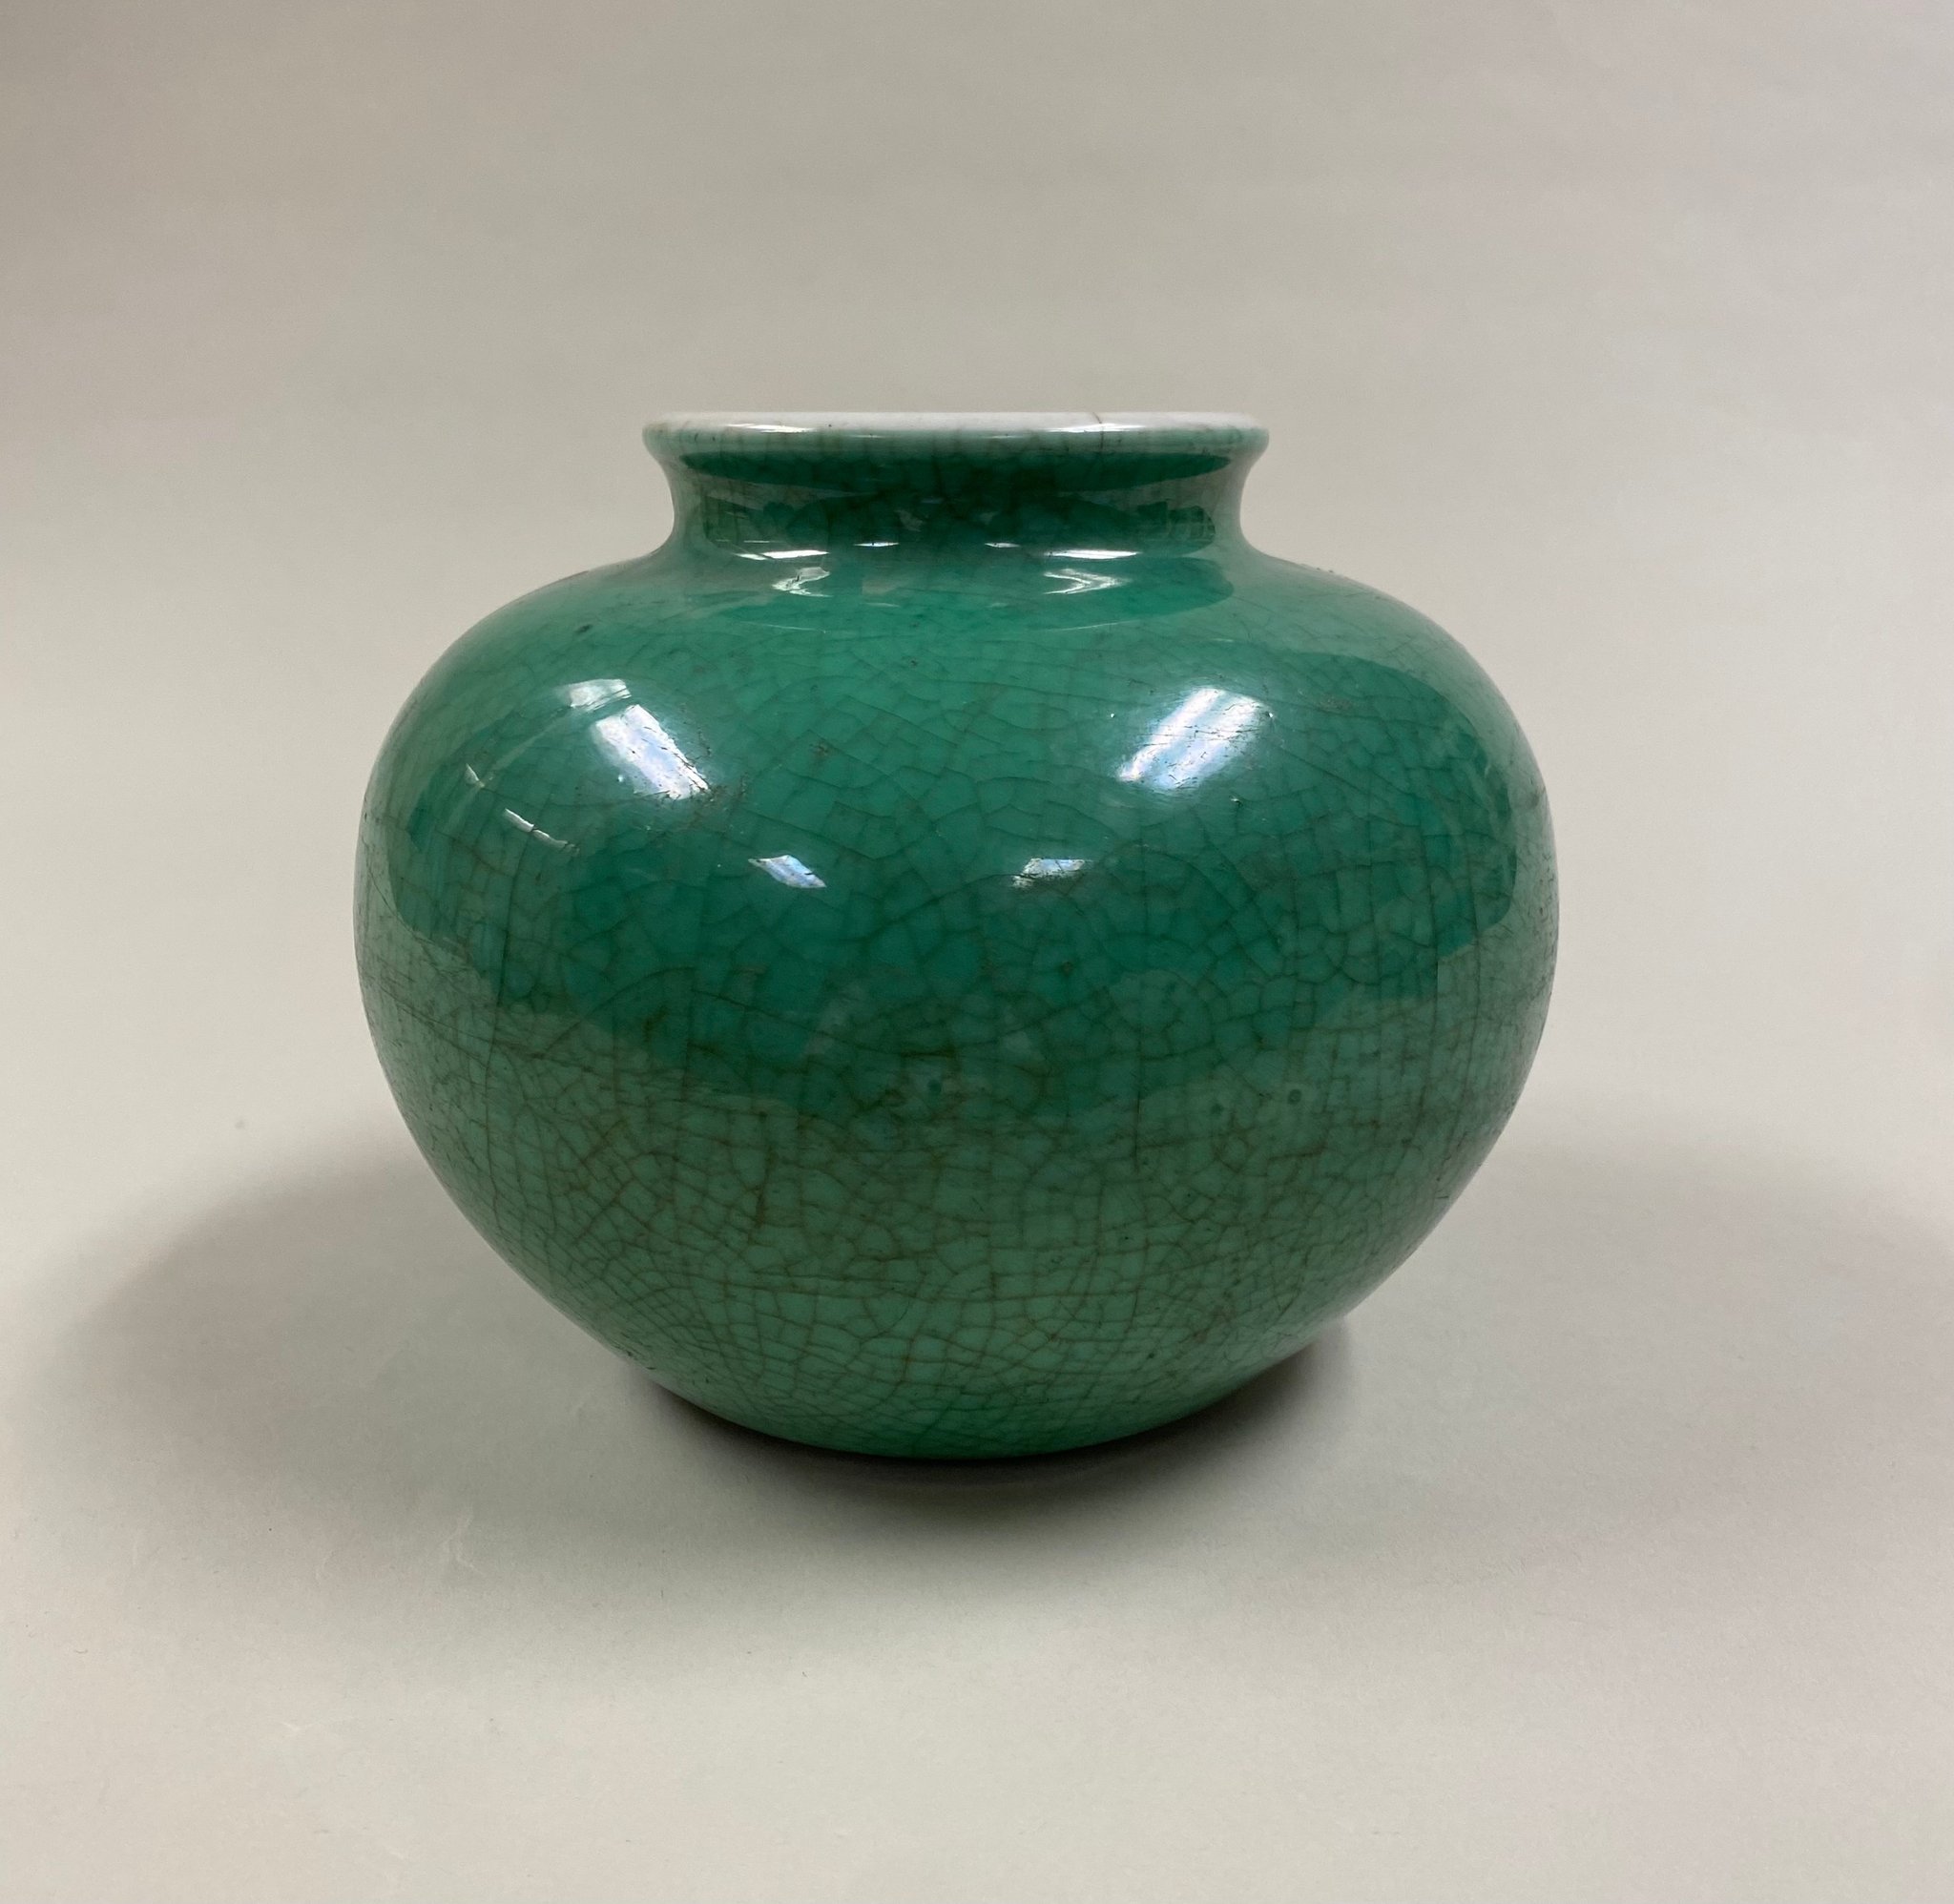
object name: jar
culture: chinese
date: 1667-1733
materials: glaze, porcelain